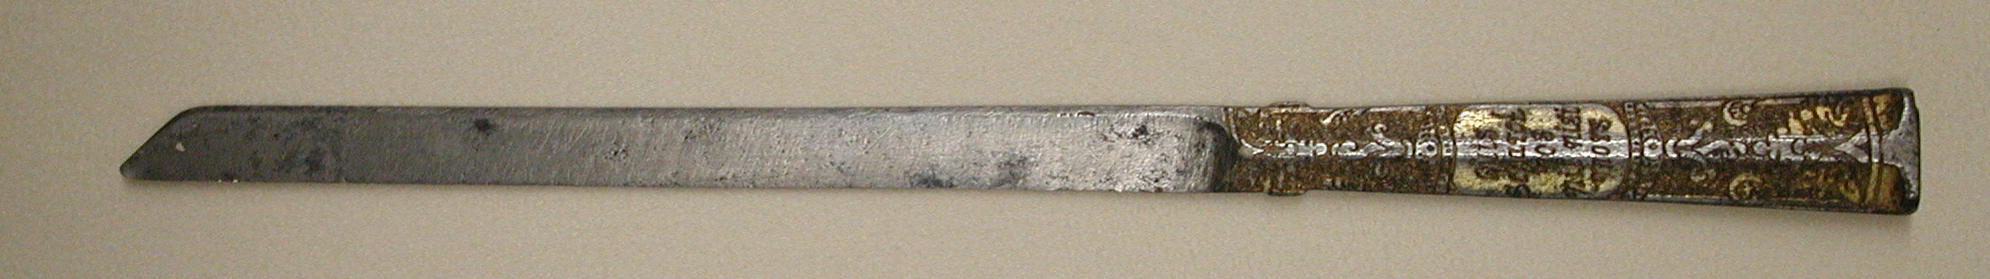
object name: knife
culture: italian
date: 1701-1800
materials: gold, steel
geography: italy